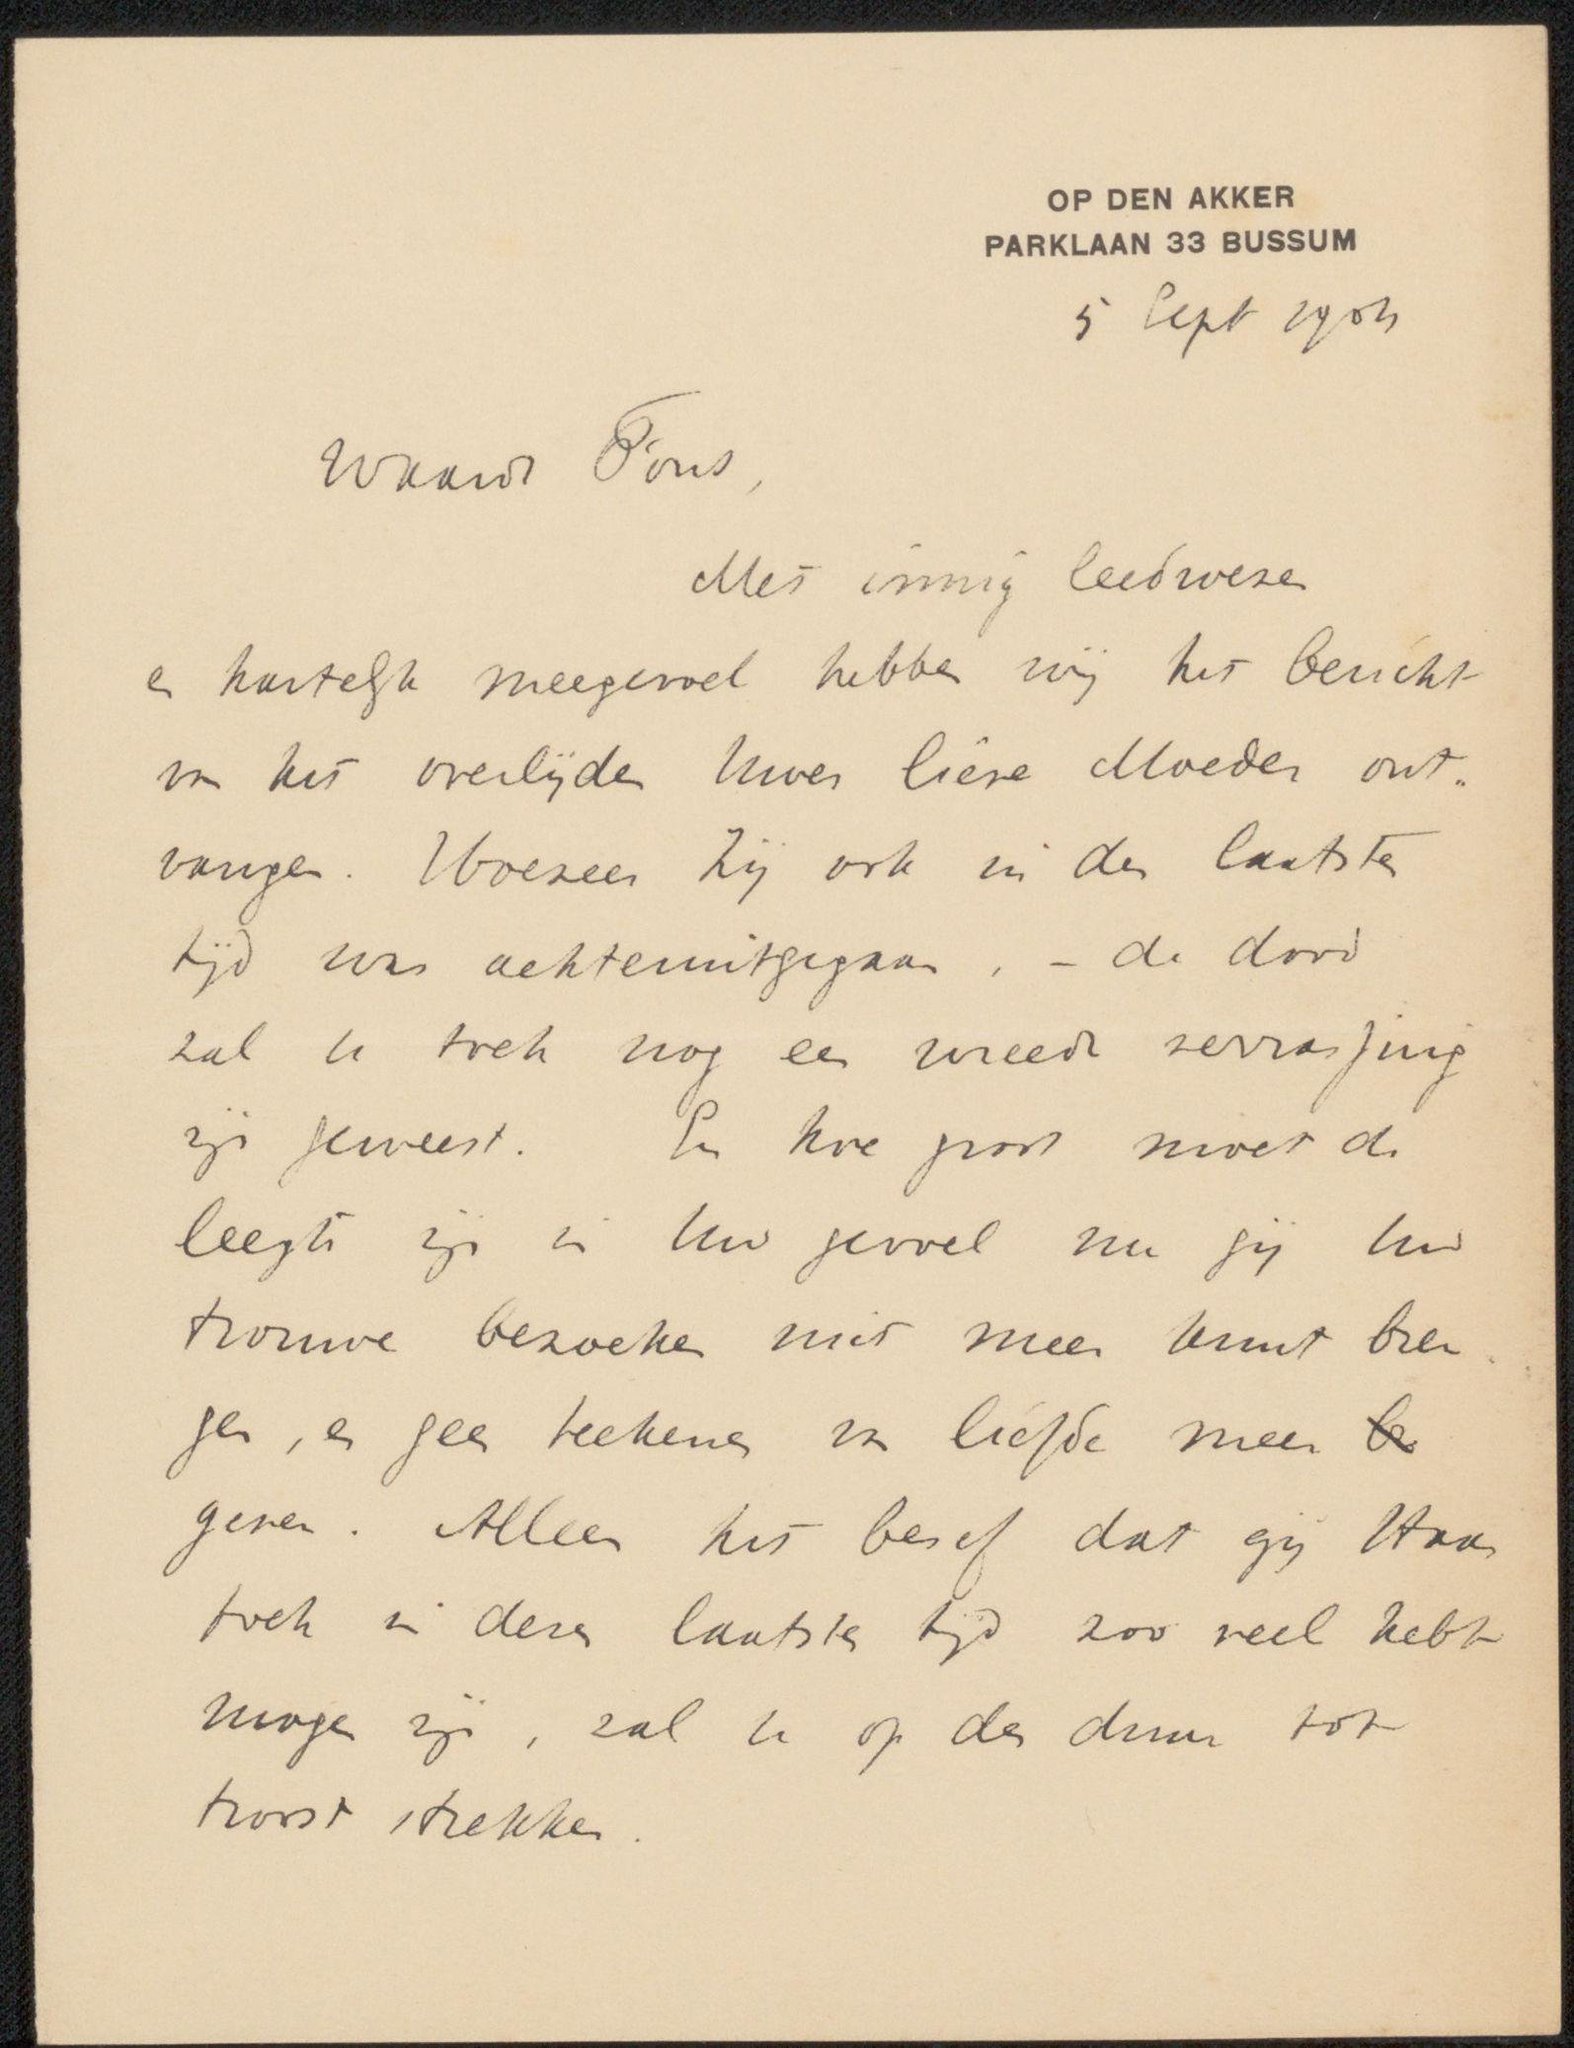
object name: letter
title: Brief aan Alphons Diepenbrock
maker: jan veth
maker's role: designer, draughtsman, painter, print maker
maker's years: 1864-1925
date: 1904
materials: ink, paper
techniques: pen, printing, writing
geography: bussum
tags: alphons diepenbrock, family life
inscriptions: collector's mark: ‘RPK’, watermark